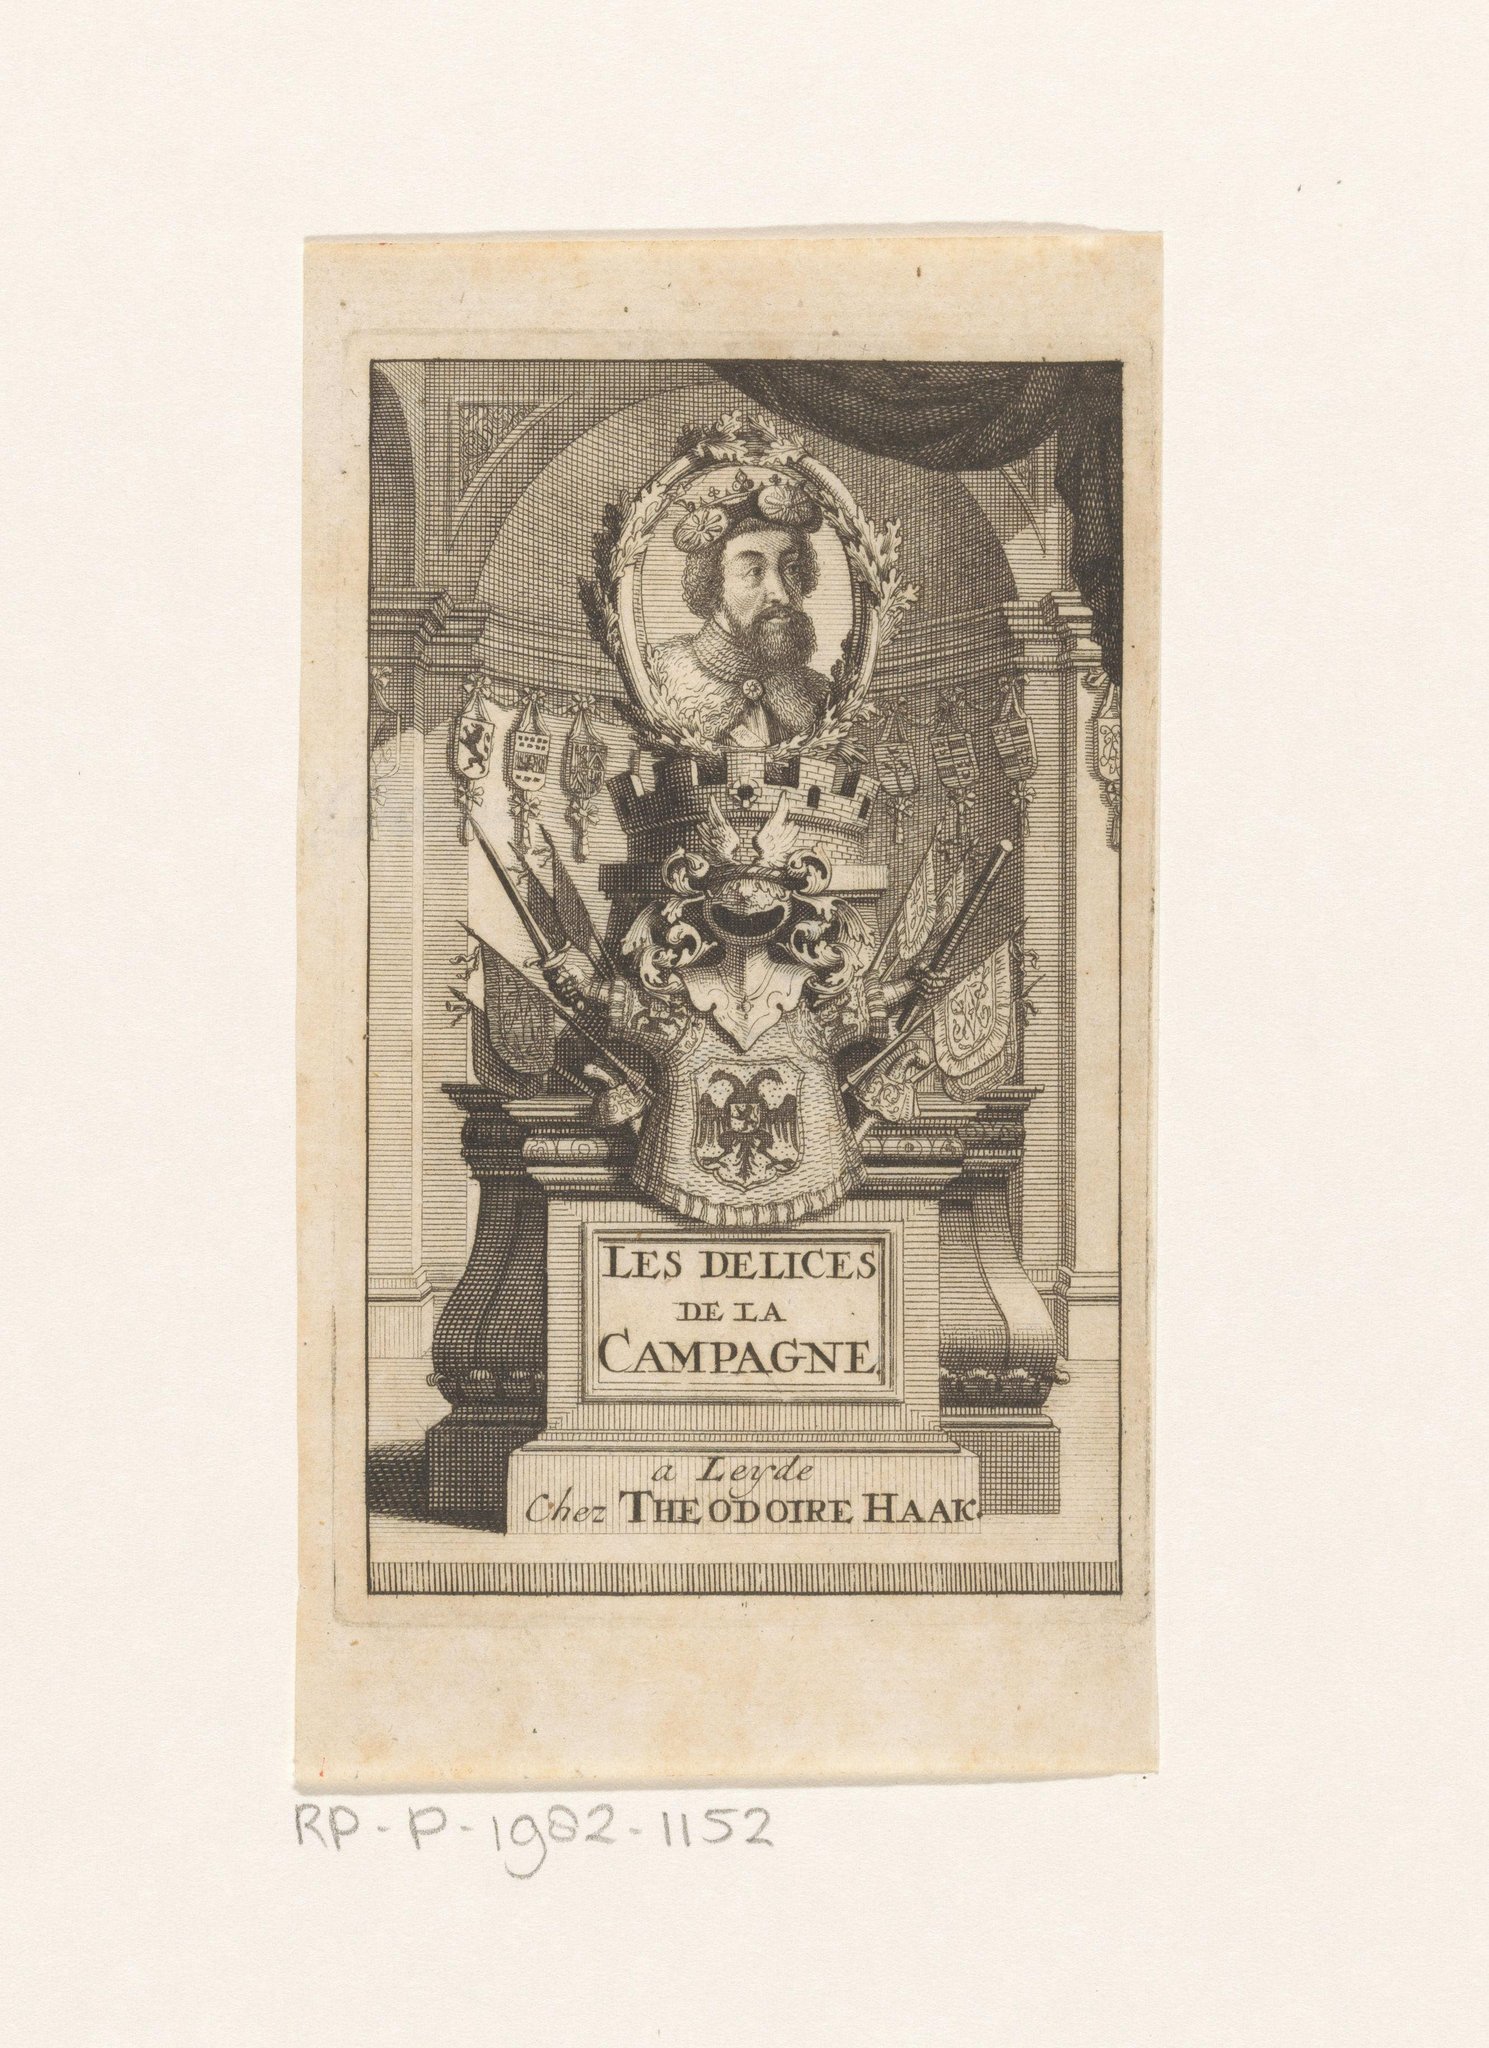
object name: print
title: Titelpagina voor: Gerard Goris, Les Délices de la campagne à l'entour de la ville de Leide, 1712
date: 1712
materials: paper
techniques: engraving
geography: leiden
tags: ghent, charles v (holy roman emperor and king of spain), pedestal of a piece of sculpture (perhaps in the form of a herm), historical persons (portraits and scenes from the life)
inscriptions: collector's mark: Lugt 2760, collector's mark: Lugt 2228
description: Titelpagina voor: Goris, Gerard. Les Délices de la campagne à l'entour de la ville de Leide. Leiden: Haak, Dirk (I), 1712. Het afgedrukte portret beeldt waarschijnlijk Karel V uit, maar het is onduidelijk wat hij met de inhoud van het boek te maken heeft.